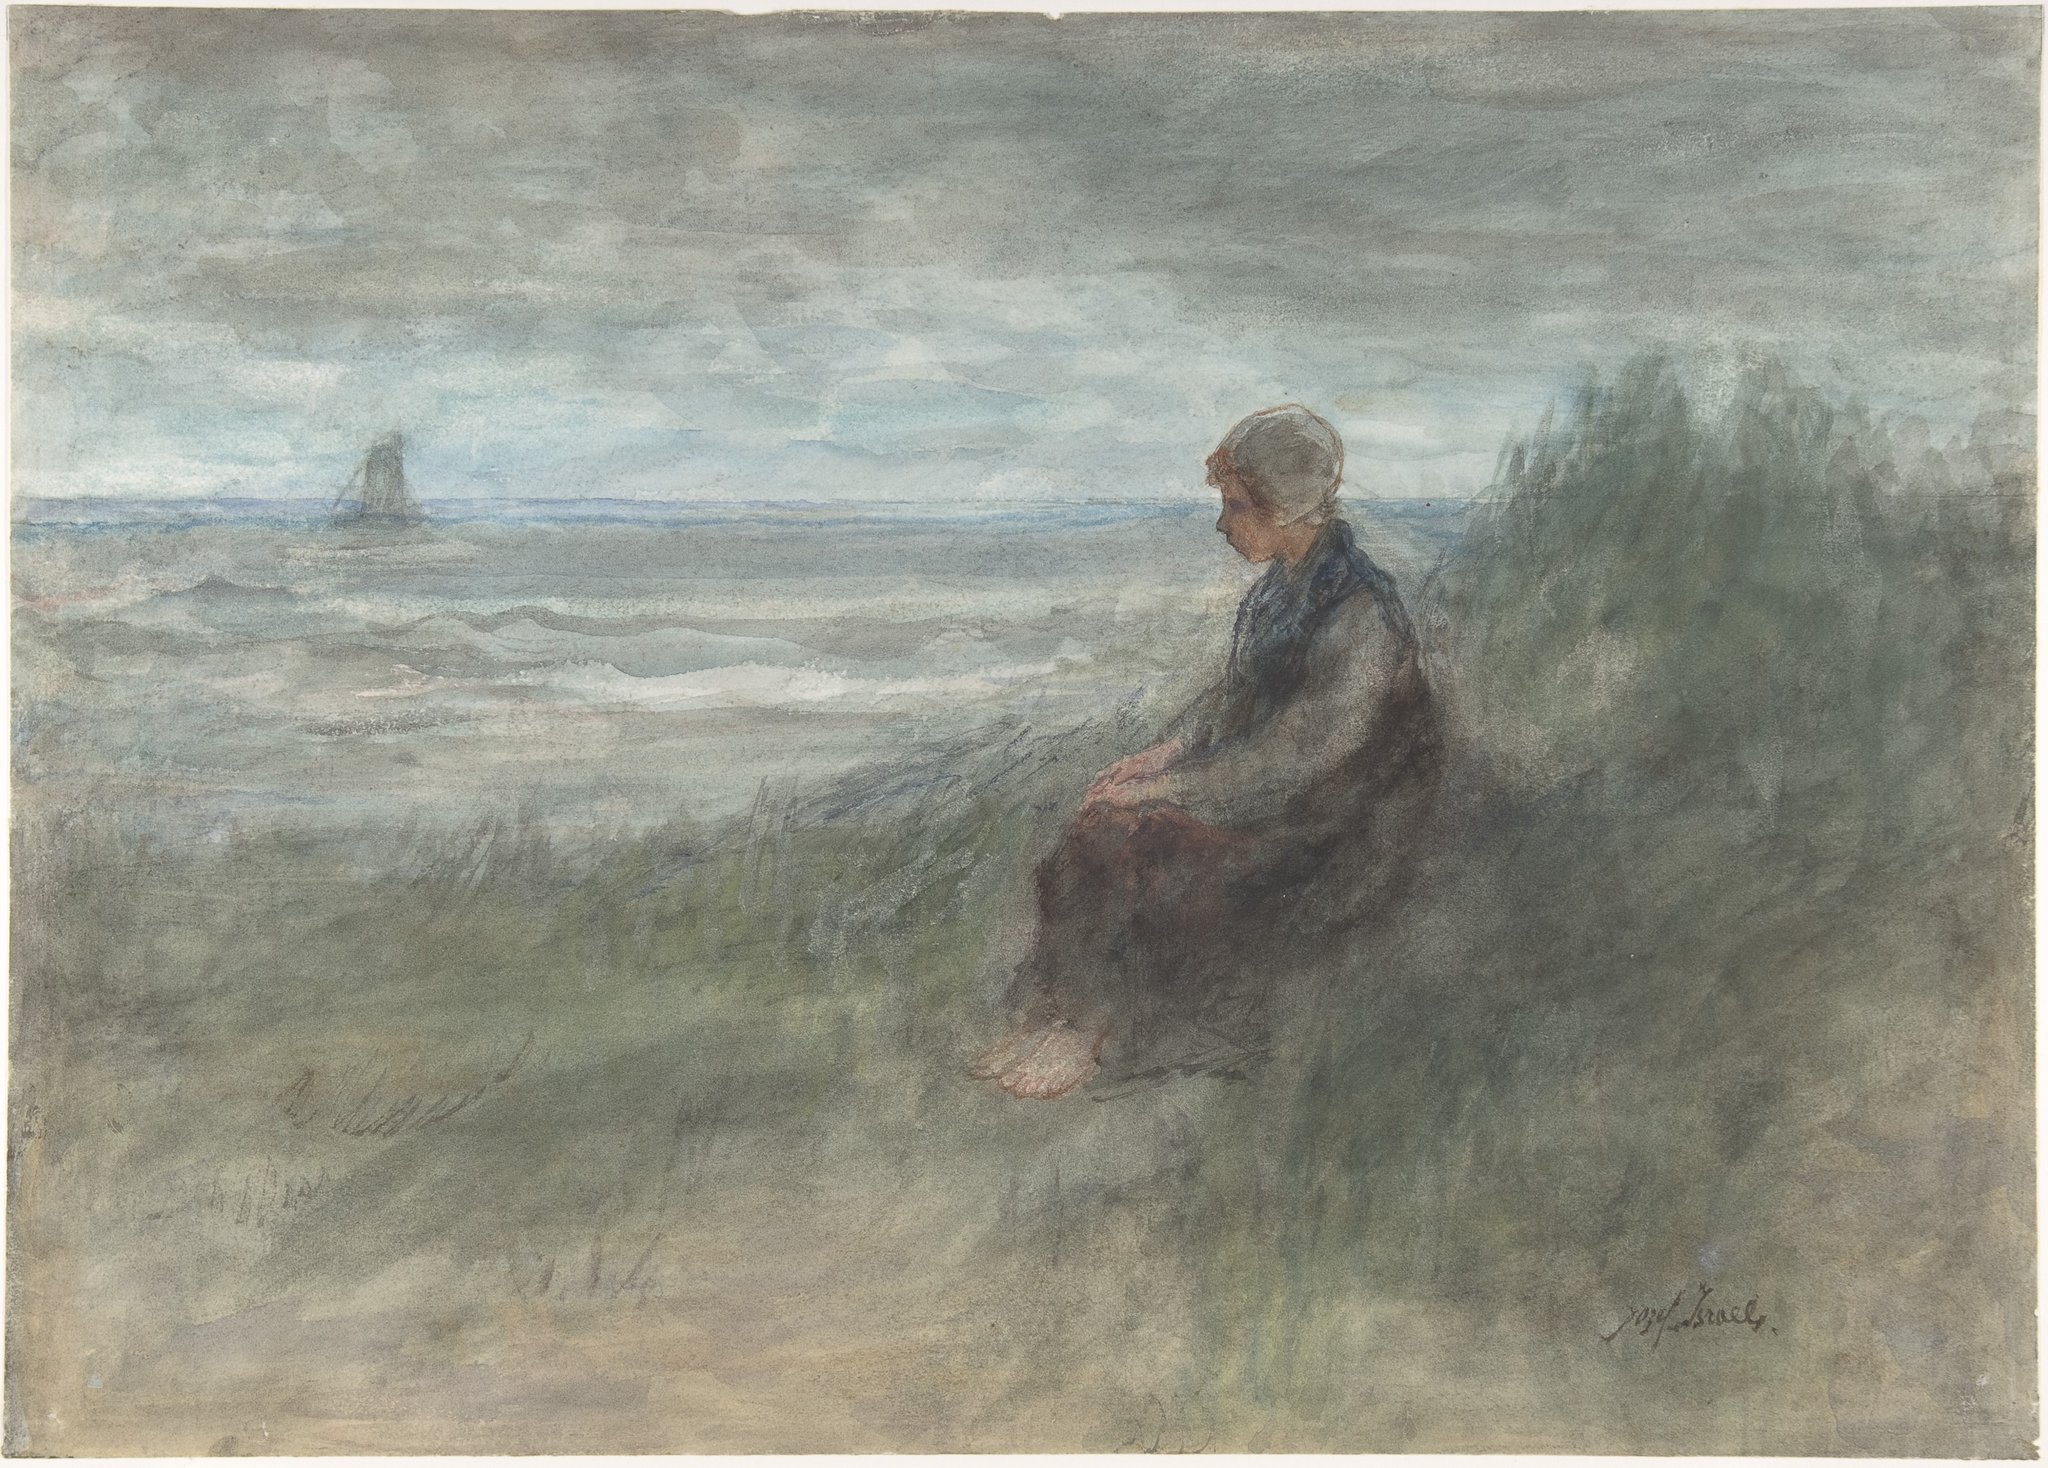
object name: drawing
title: Girl in the Dunes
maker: jozef israëls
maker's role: artist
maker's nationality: dutch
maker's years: 1824-1911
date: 1834-1933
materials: chalk, watercolor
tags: girls,landscapes,boats